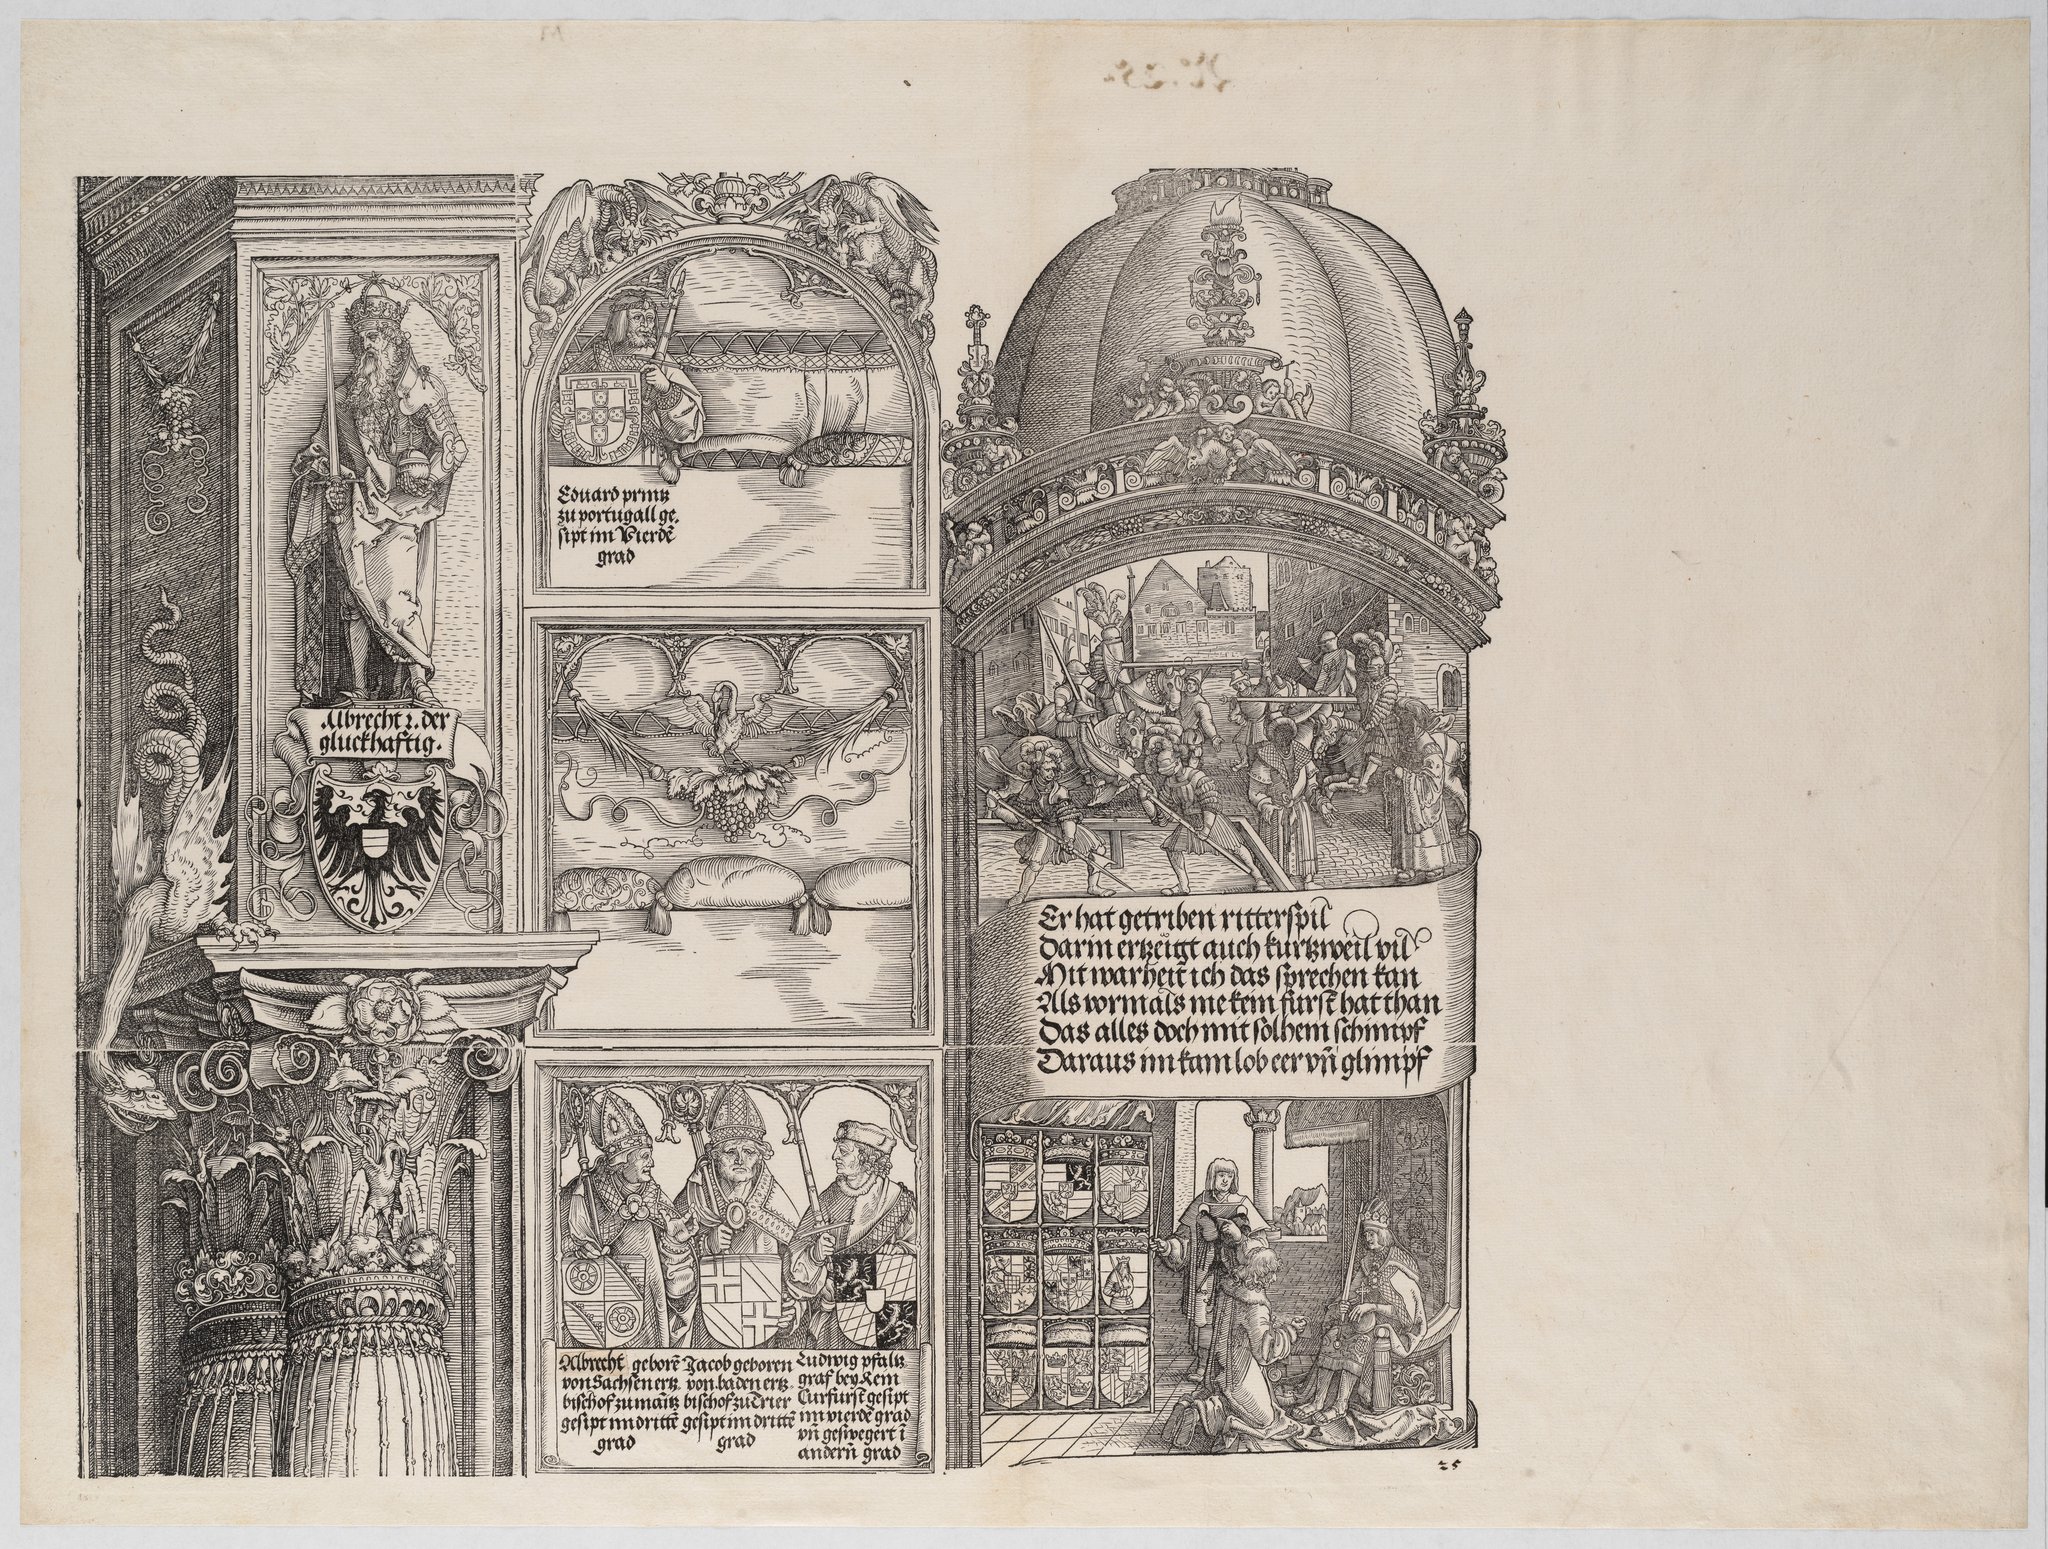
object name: print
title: Tournaments and Masquerades; and Maximilian's Genealogical and Heraldic Studies; with a Statue of Albrecht the Lucky; and Portraits of Maximilian's Ancestors and Relatives,from the Arch of Honor, proof, dated 1515, printed 1517-18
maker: albrecht altdorfer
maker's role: artist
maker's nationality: german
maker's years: 1480-1538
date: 1515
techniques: letterpress, woodcut